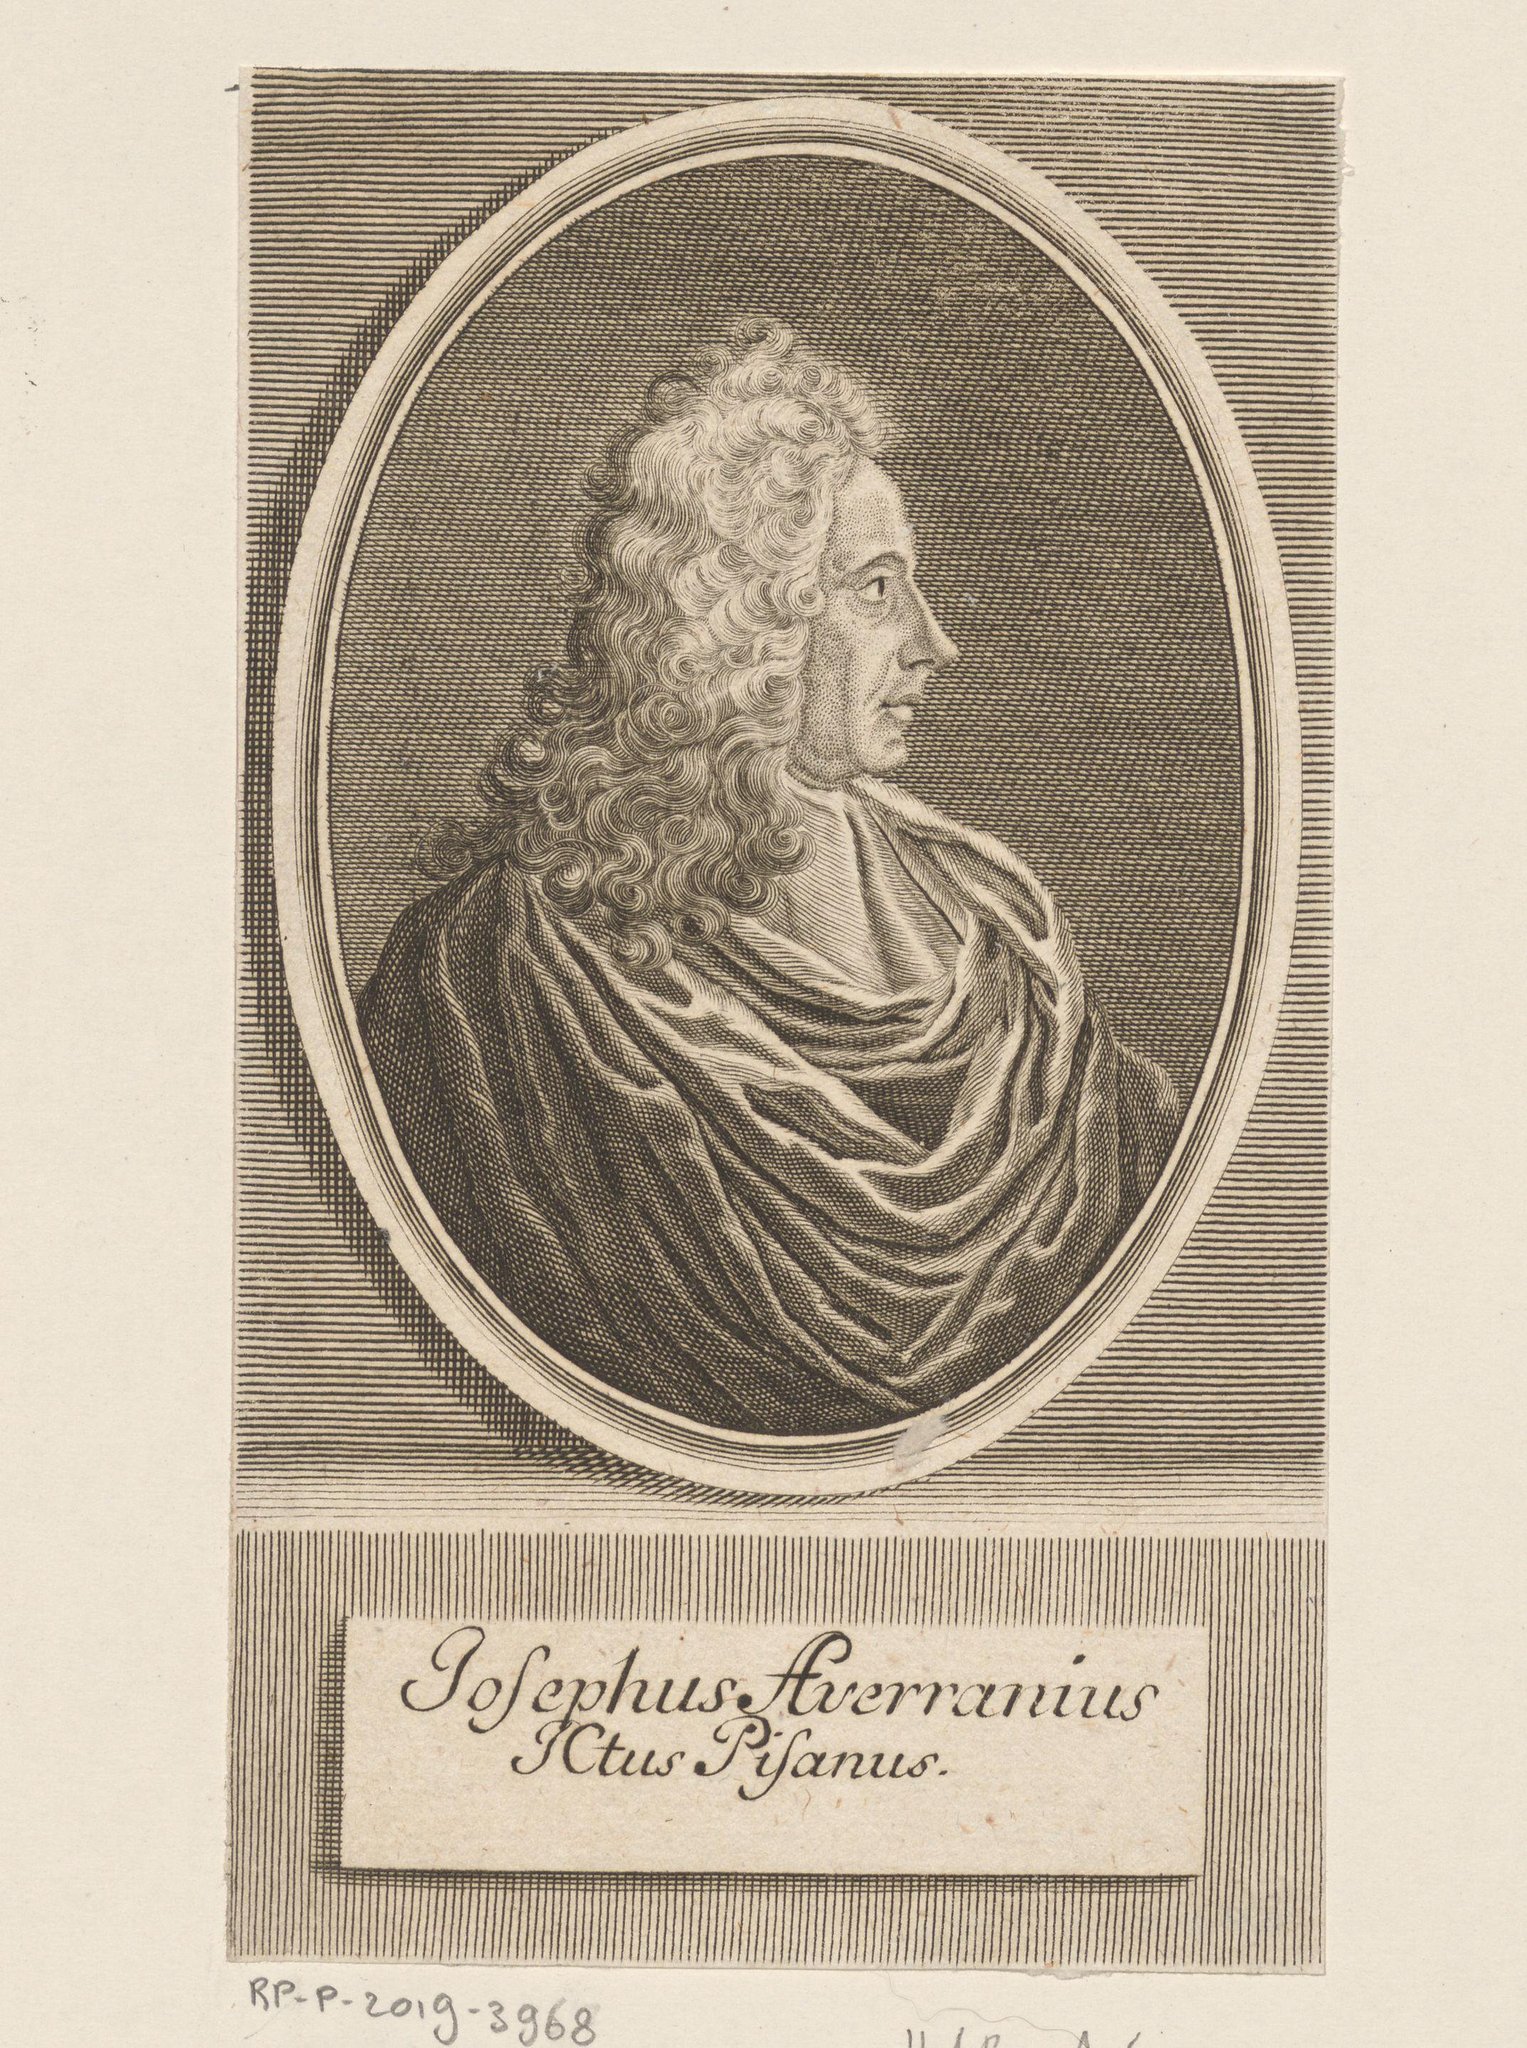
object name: print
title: Portret van Josephus Averanius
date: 1739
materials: paper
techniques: engraving, etching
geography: leipzig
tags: historical persons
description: Prent uit: Deutsche Acta Eruditorum. Leipzig: Johann Friedrich Gleditsch, 1739, dl. 232.